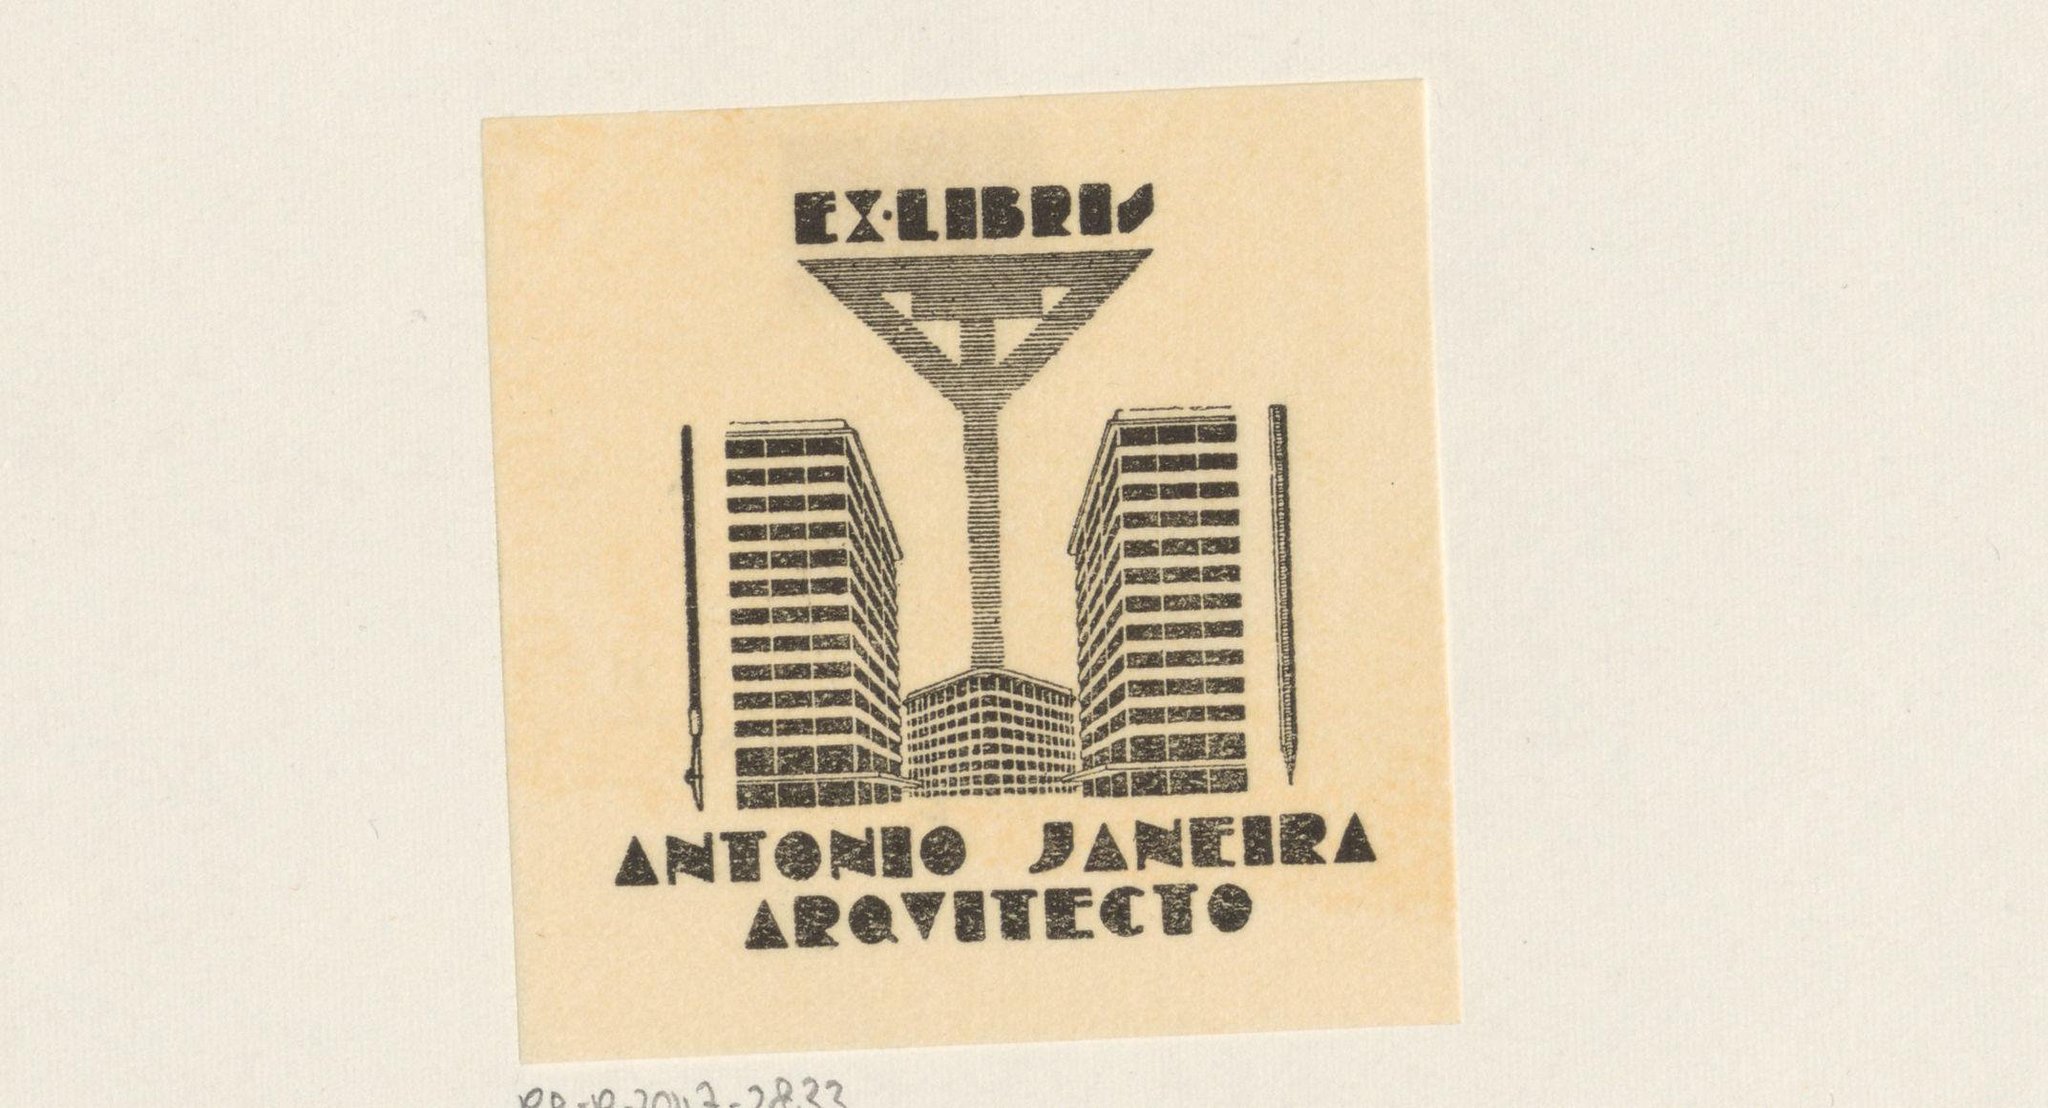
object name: bookplate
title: Ex libris van Antonio Janeira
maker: Anonymous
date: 1929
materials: paper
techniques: printing block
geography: portugal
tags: flat-building, apartment house, pencil, tools, implements of architect